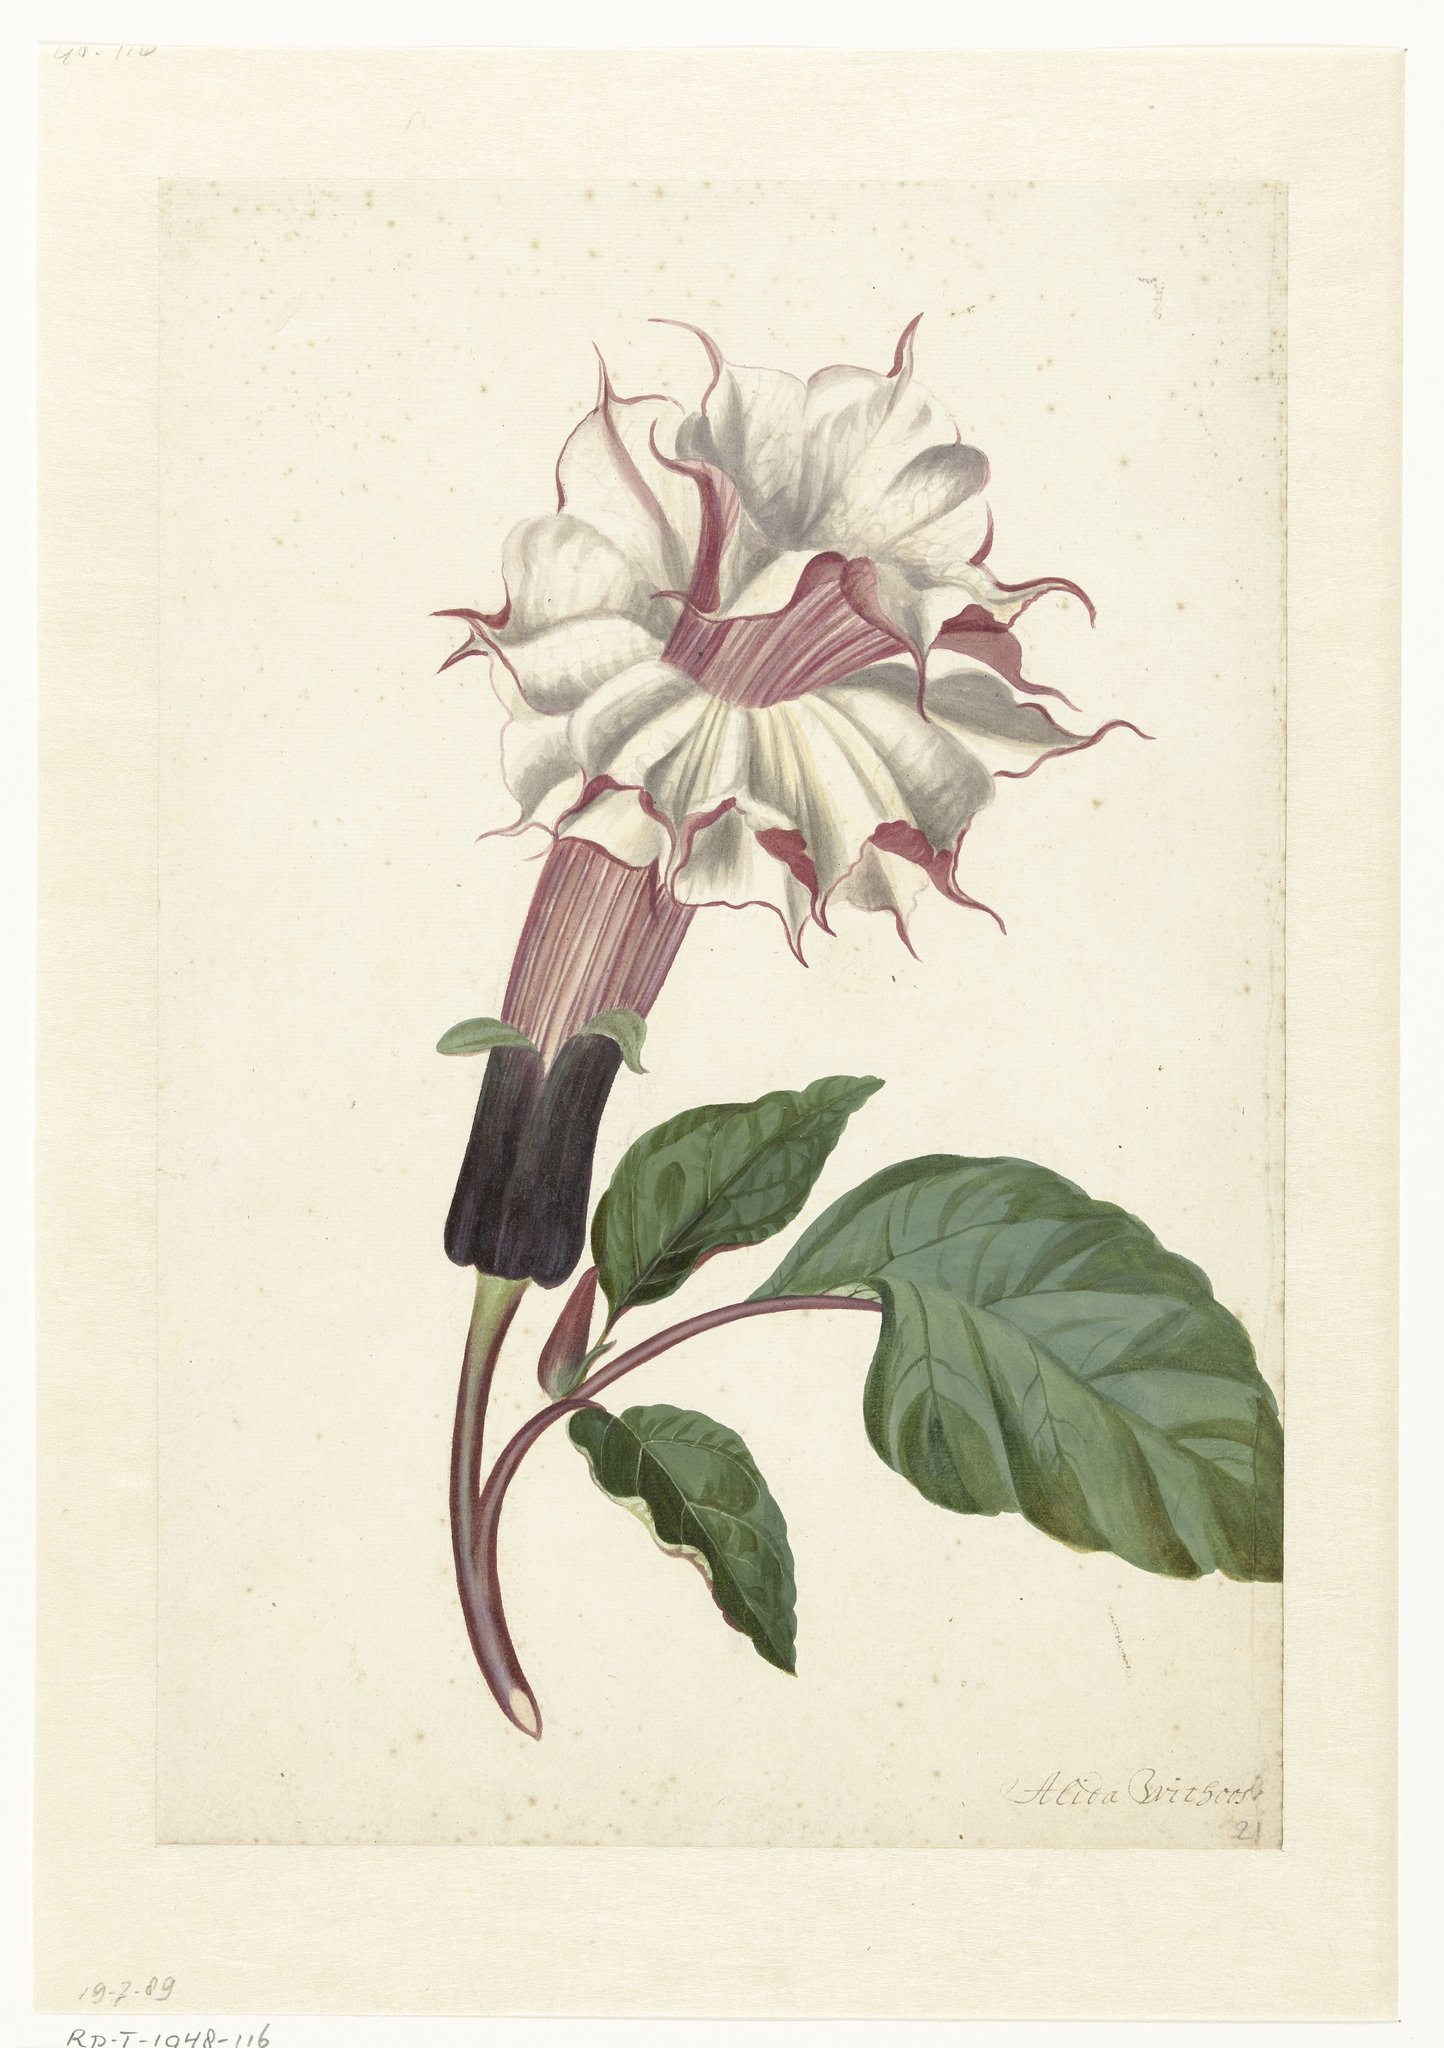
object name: watercolor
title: Indian Thornapple (Datura metel)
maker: alida withoos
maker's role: draughtsman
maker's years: 1659-1730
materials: paper, watercolor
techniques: brush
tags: flowers: datura fastuosa